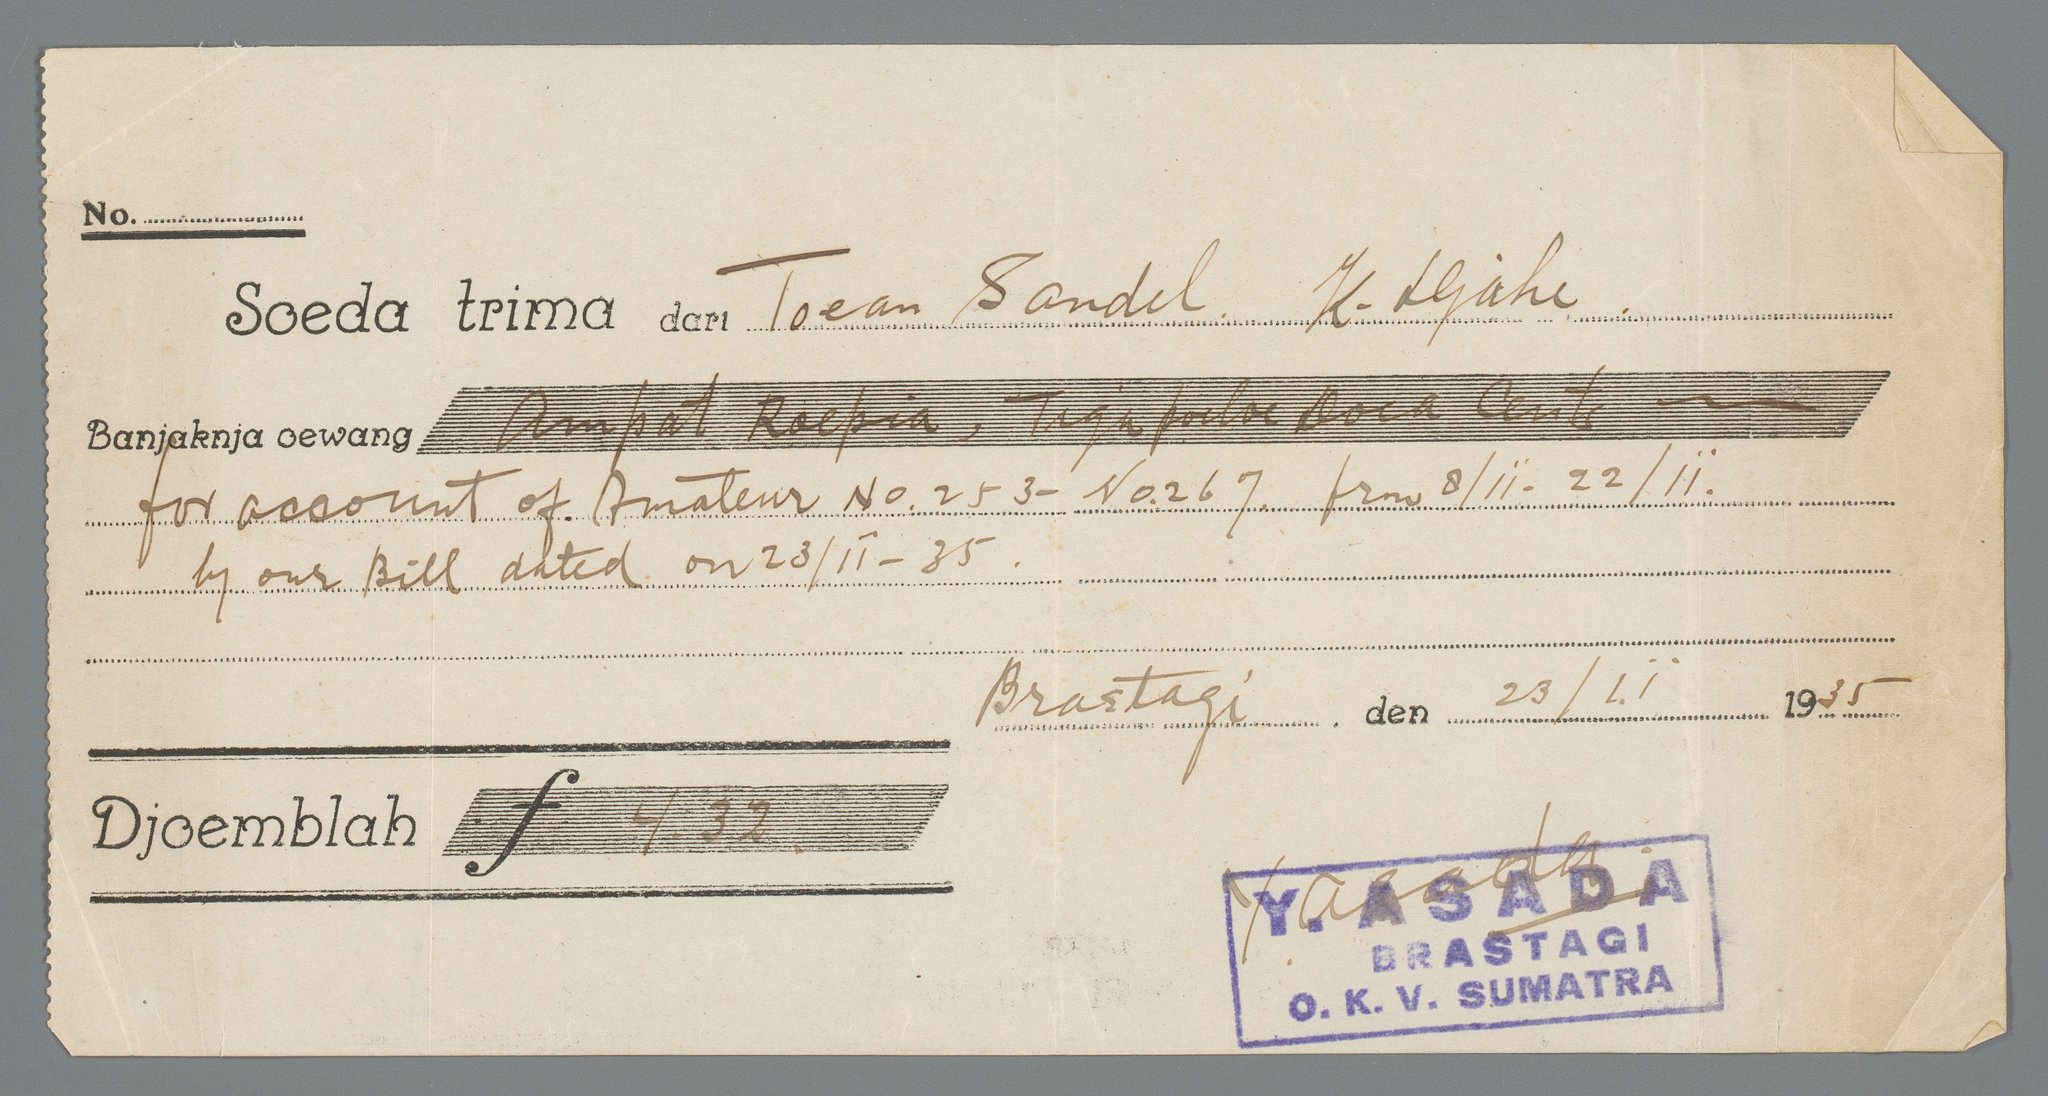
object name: document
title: Waardecheque aan Toean Sandel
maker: Anonymous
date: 1935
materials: paper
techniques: letterpress printing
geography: sumatra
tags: cheque, draft, bill of exchange, sumatra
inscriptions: stamp: ‘Y. ASADA/ BRASTAGI/ O. K. V. SUMATRA’, inscription: ‘Soeda trima dari Toean Sandel. K-djahi./ Bankjaknja oewang Ampat roepia, tiga poeloe dloca cents - (...)’